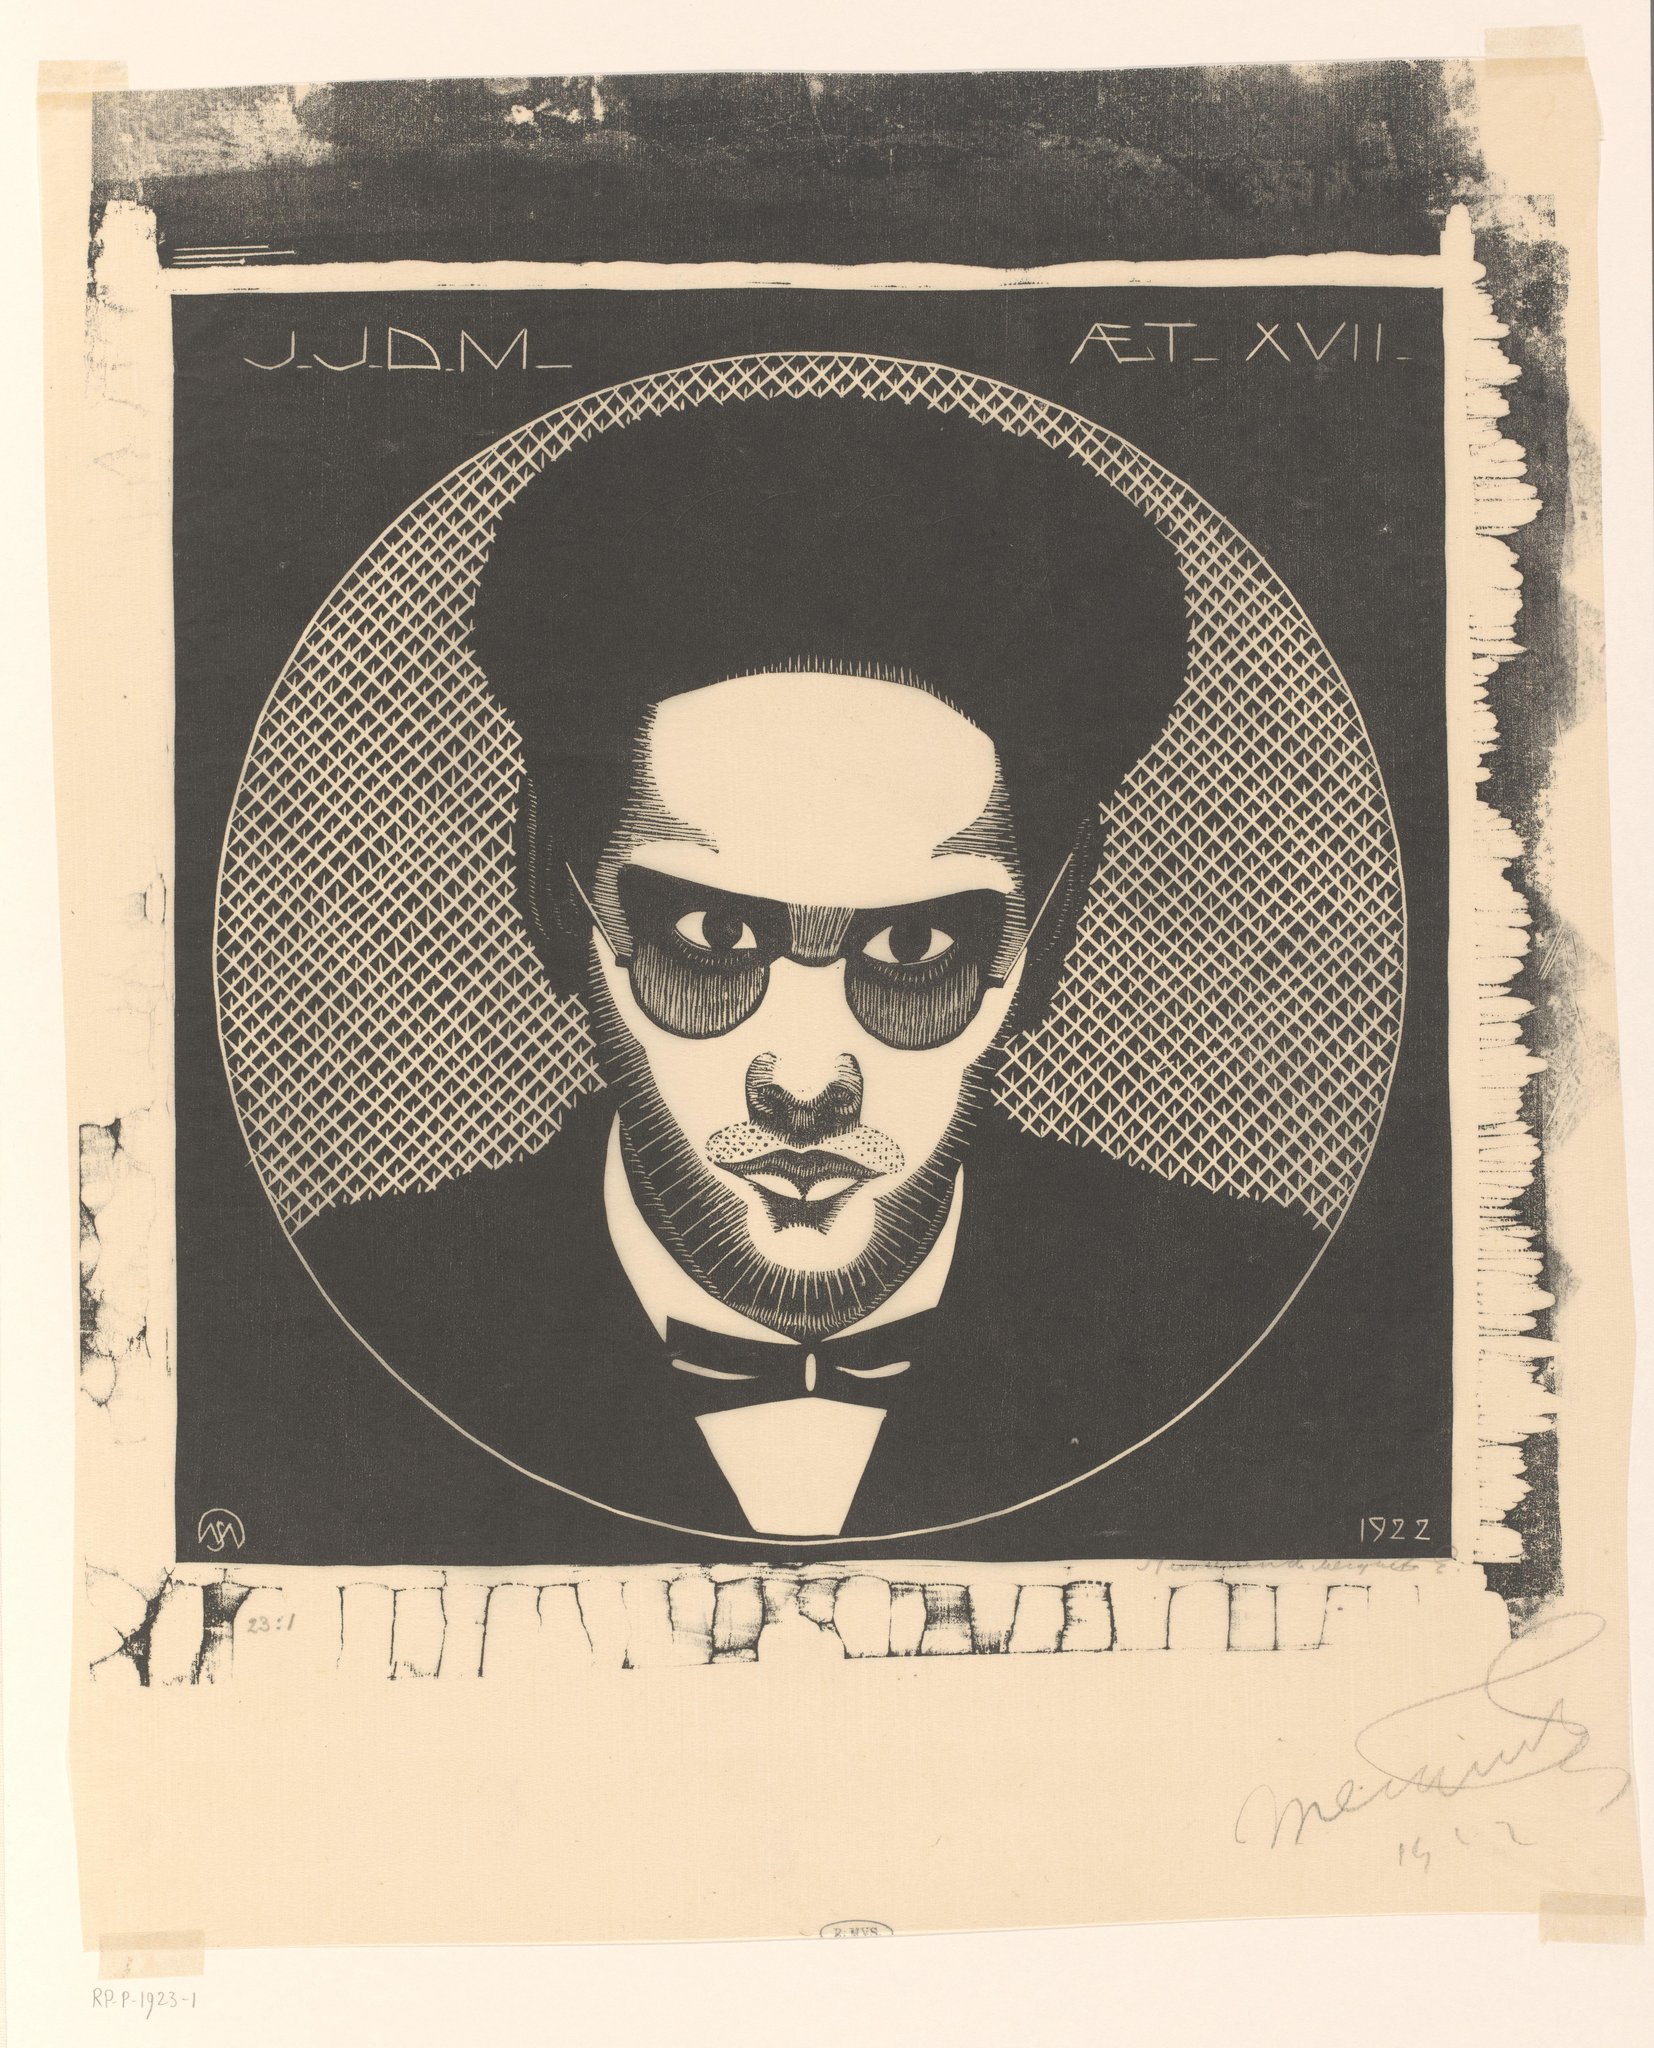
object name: print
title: Portrait of Jaap Jessurun de Mesquita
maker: samuel jessurun de mesquita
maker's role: draughtsman, print maker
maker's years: 1868-1944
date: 1922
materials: paper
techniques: woodcut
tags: eyeglasses, spectacles, youth, adolescent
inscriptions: collector's mark: Lugt 2228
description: Betsie and Samuel’s son Jaap was born in 1905. His initials and age (17) are recorded at the top of this woodcut. Jaap studied art history and continued to live with his parents throughout his life. The family was separated while being deported, and he died in Theresienstadt on 30 March 1944.